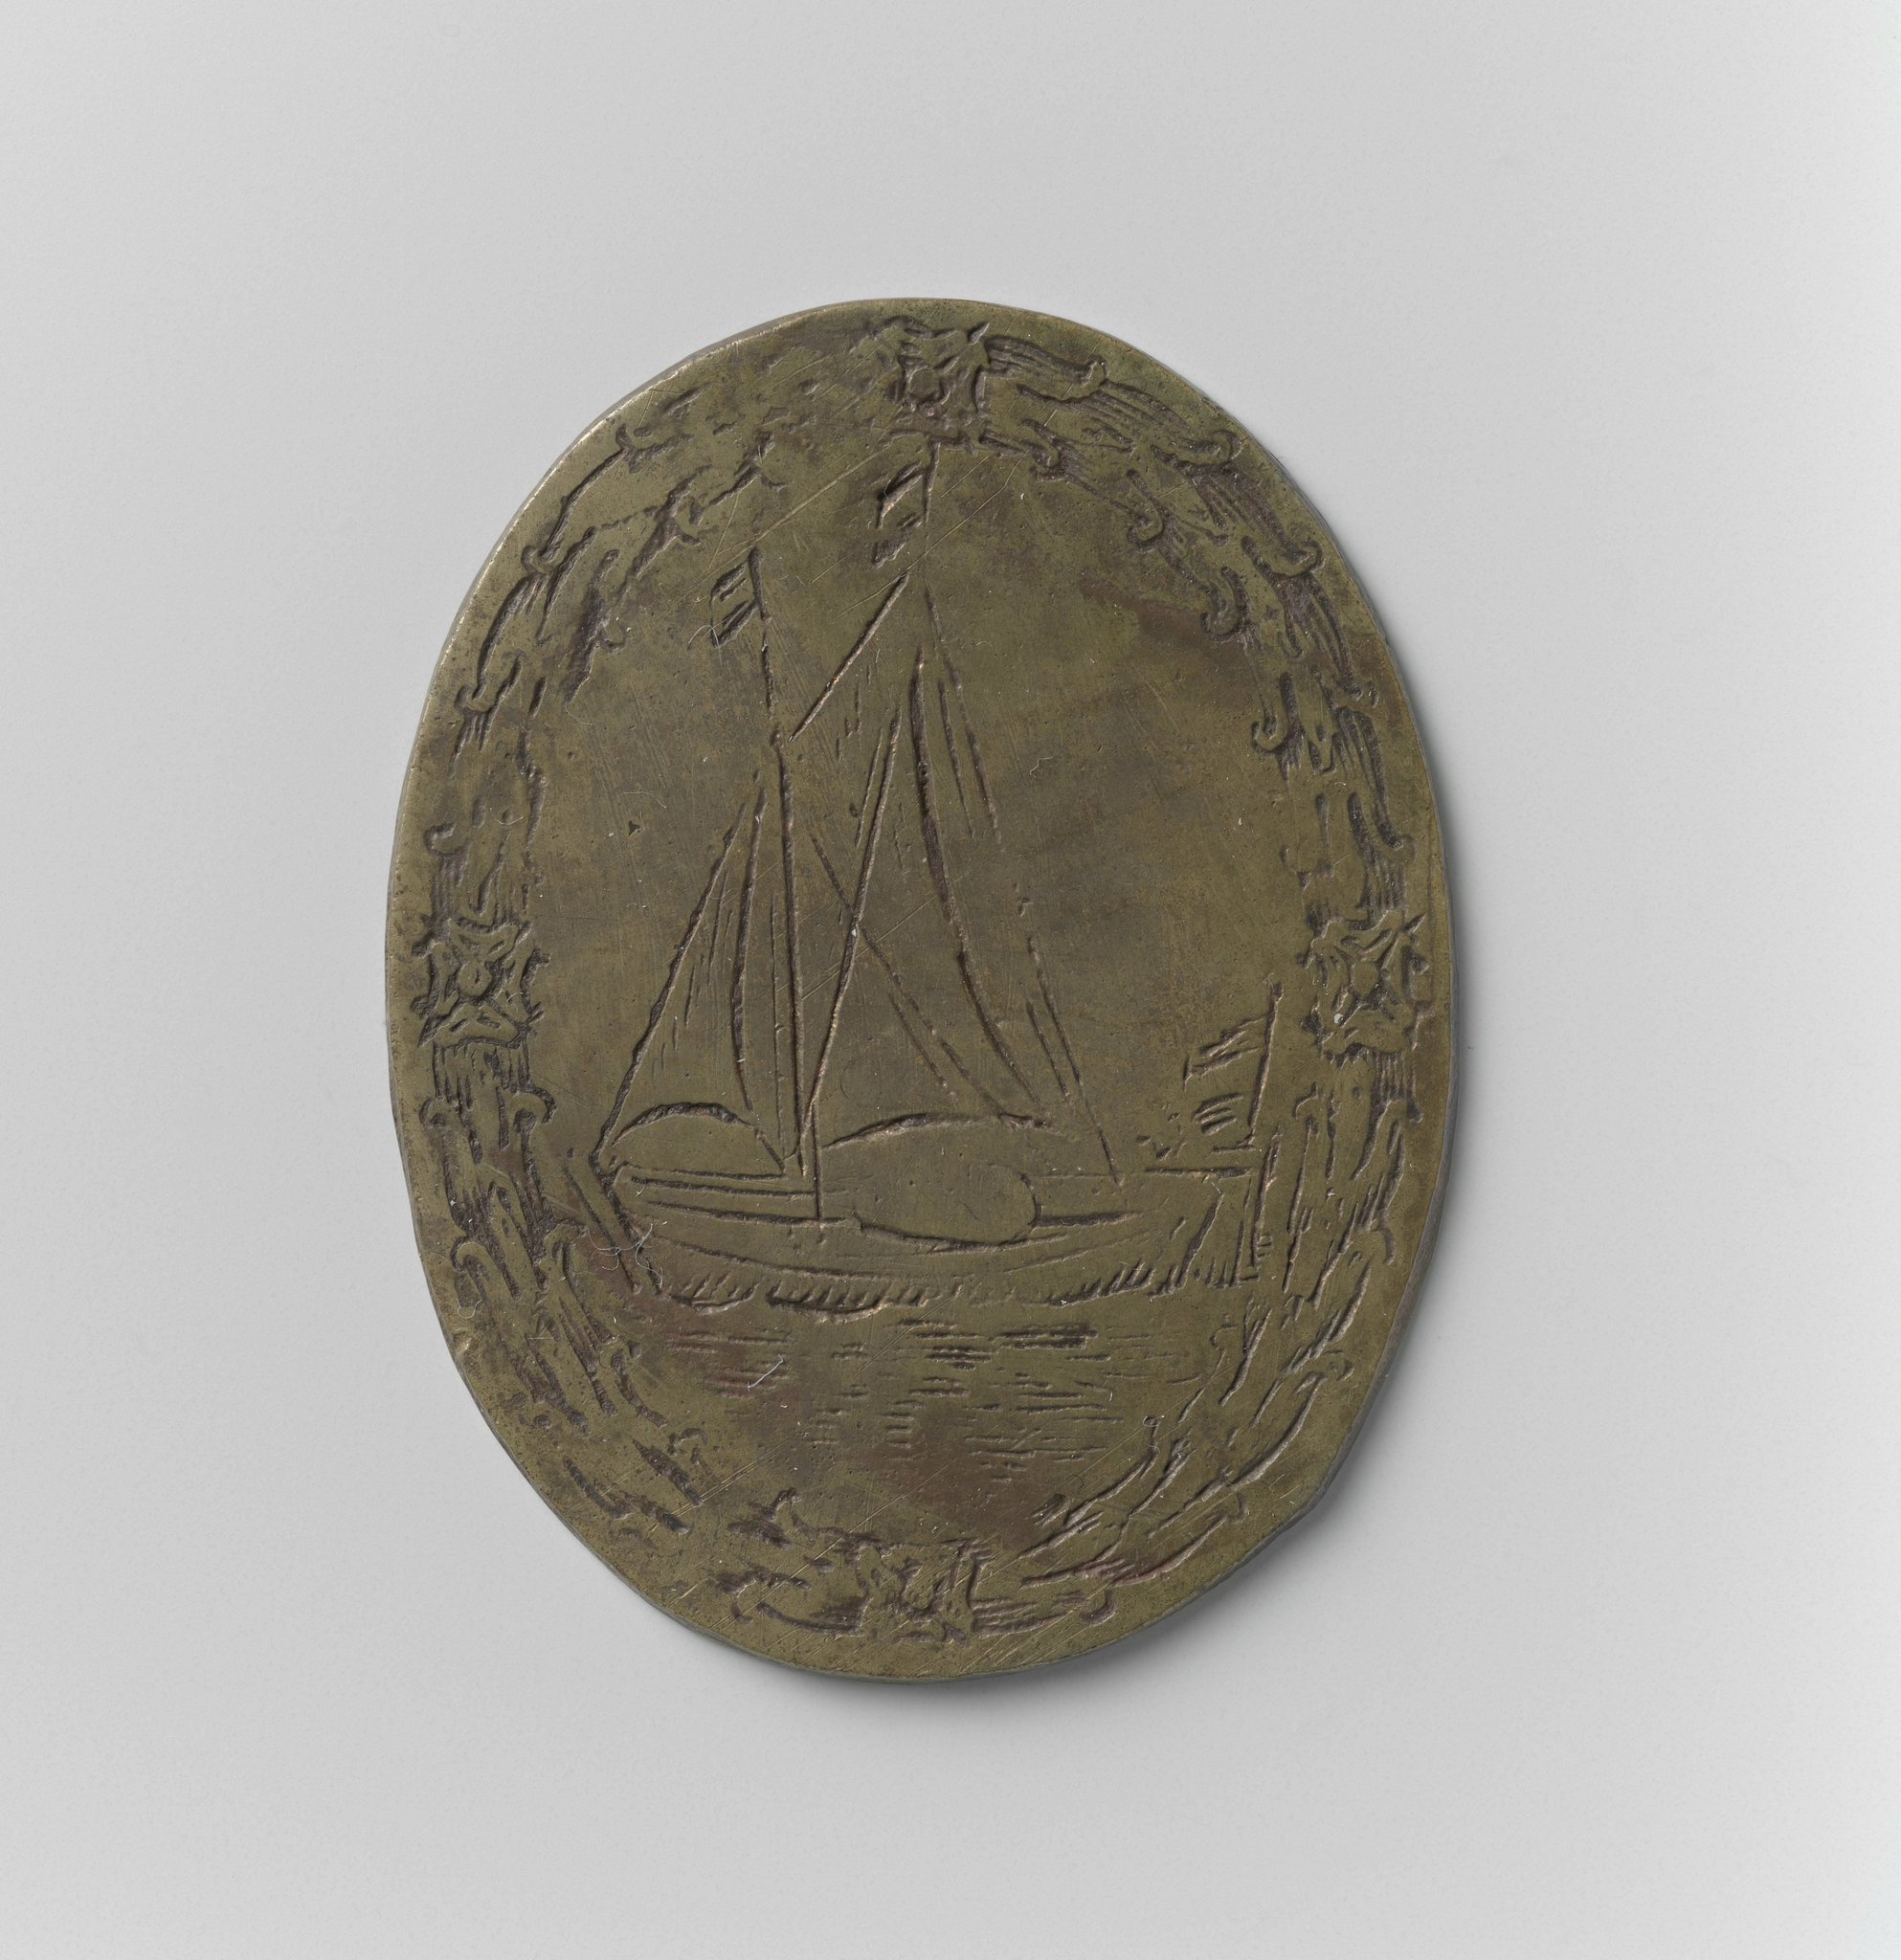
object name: medal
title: Schippersgilde, gildepenning van Jan Jansen van Gulick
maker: Anonymous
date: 1600-1800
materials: brass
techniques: engraving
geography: netherlands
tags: jan jansen van gulick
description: Messing ovale penning. Voorzijde: naar links varend schip binnen bladerkrans met vier bloemen. Keerzijde: opschrift binnen drie ringen